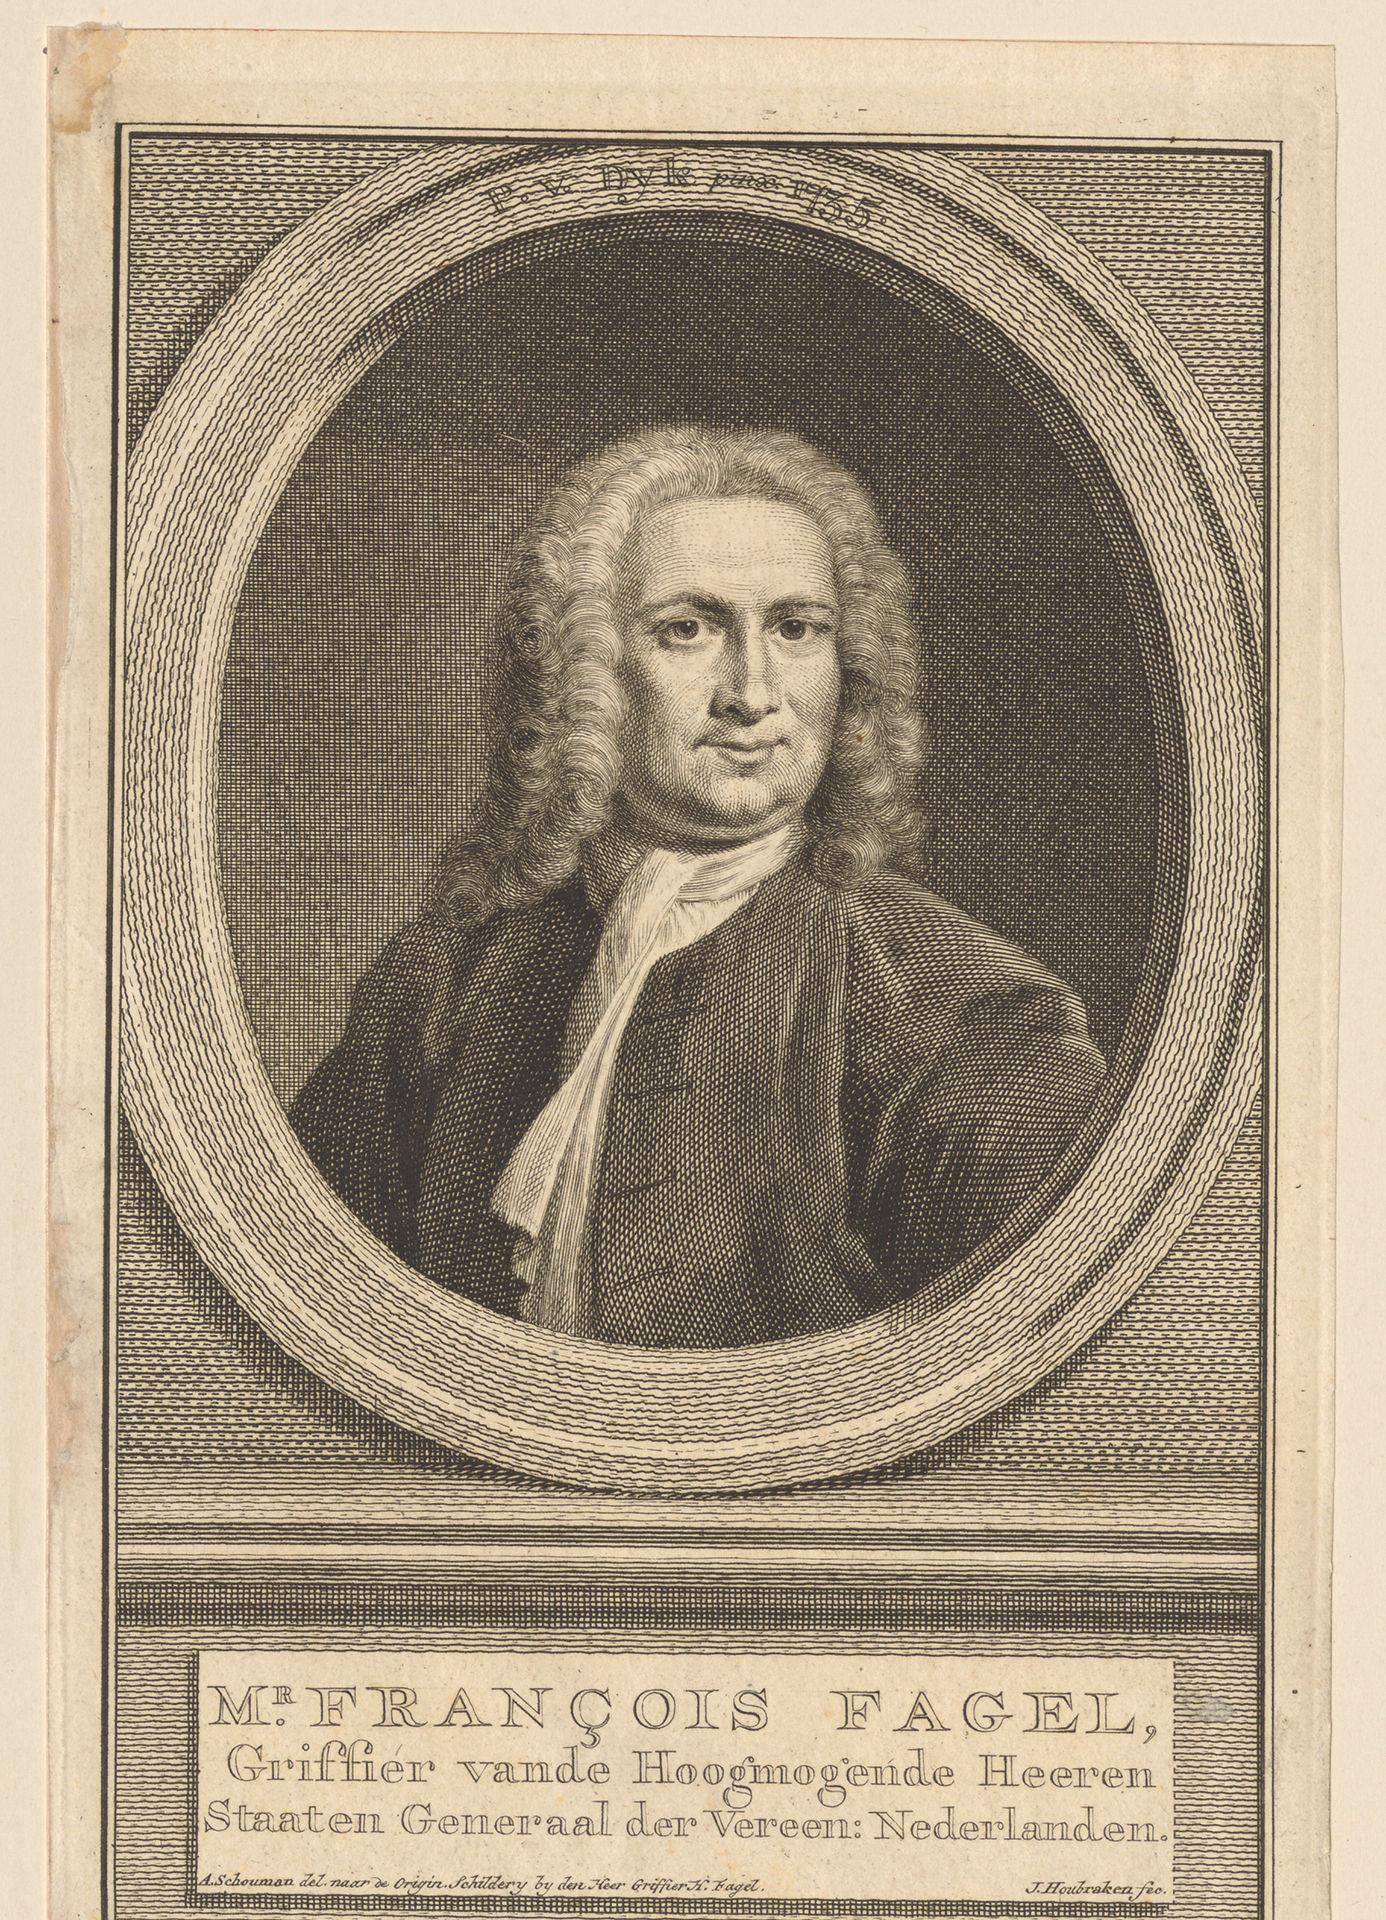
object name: book illustration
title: Portret van François Fagel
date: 1758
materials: paper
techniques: engraving, etching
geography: amsterdam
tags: the hague, historical persons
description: Prent waarschijnlijk uit: Wagenaar, Jan. Vaderlandsche historie (...). Amsterdam: Isaak Tirion, 1758, dl. 19.